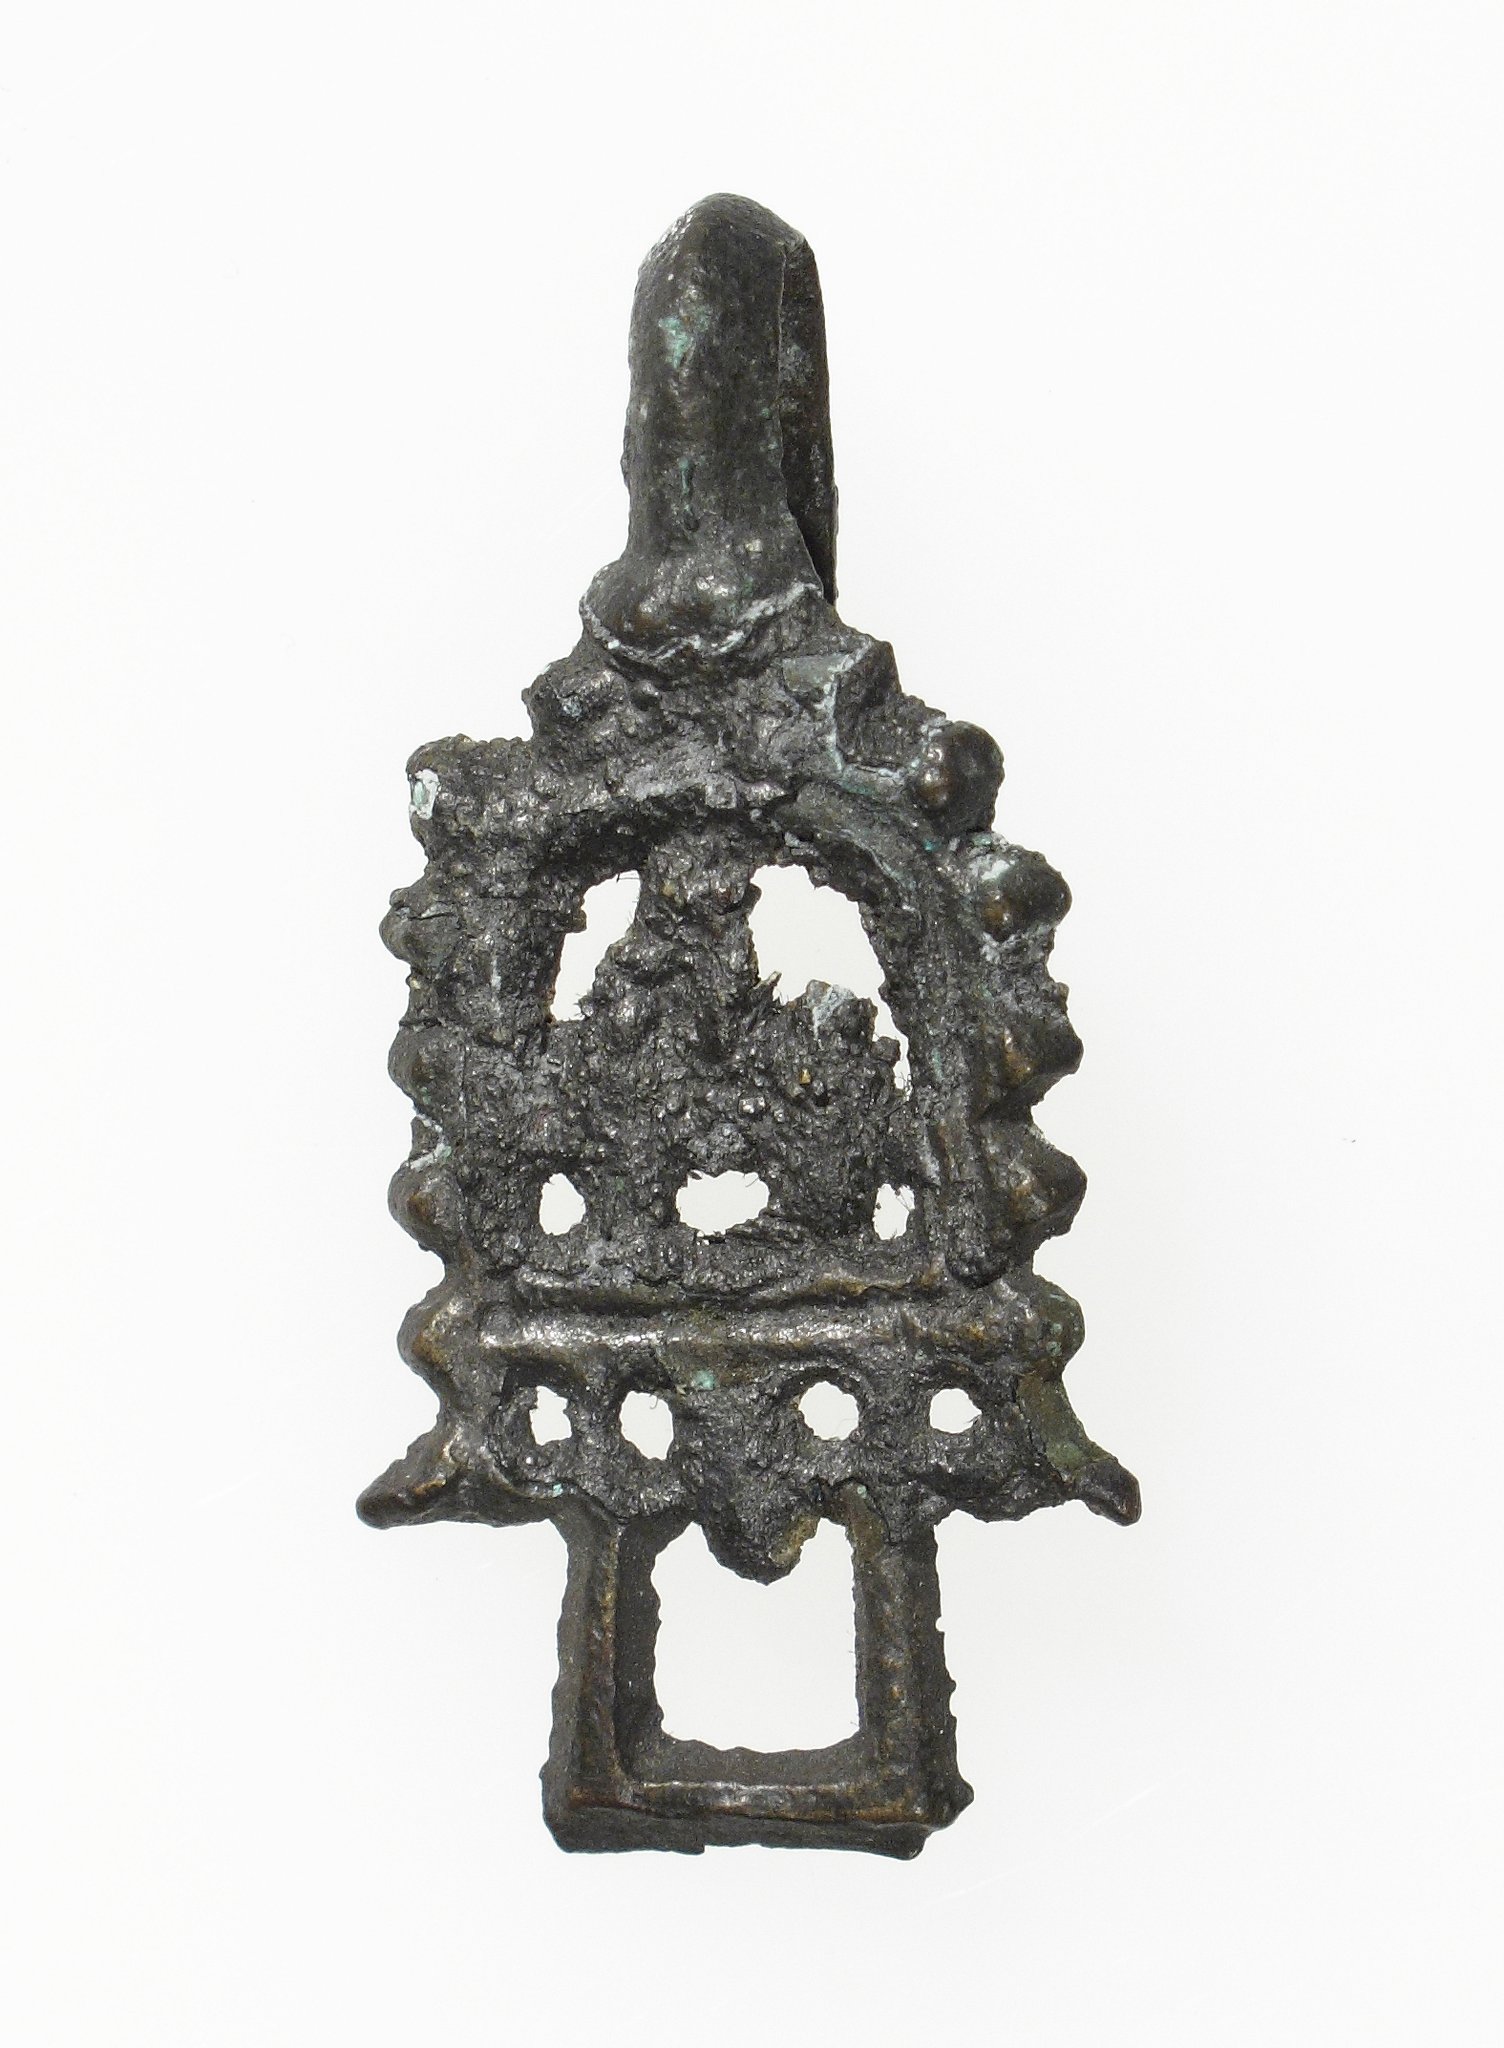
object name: pilgrim's badge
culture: french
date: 1301-1600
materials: lead